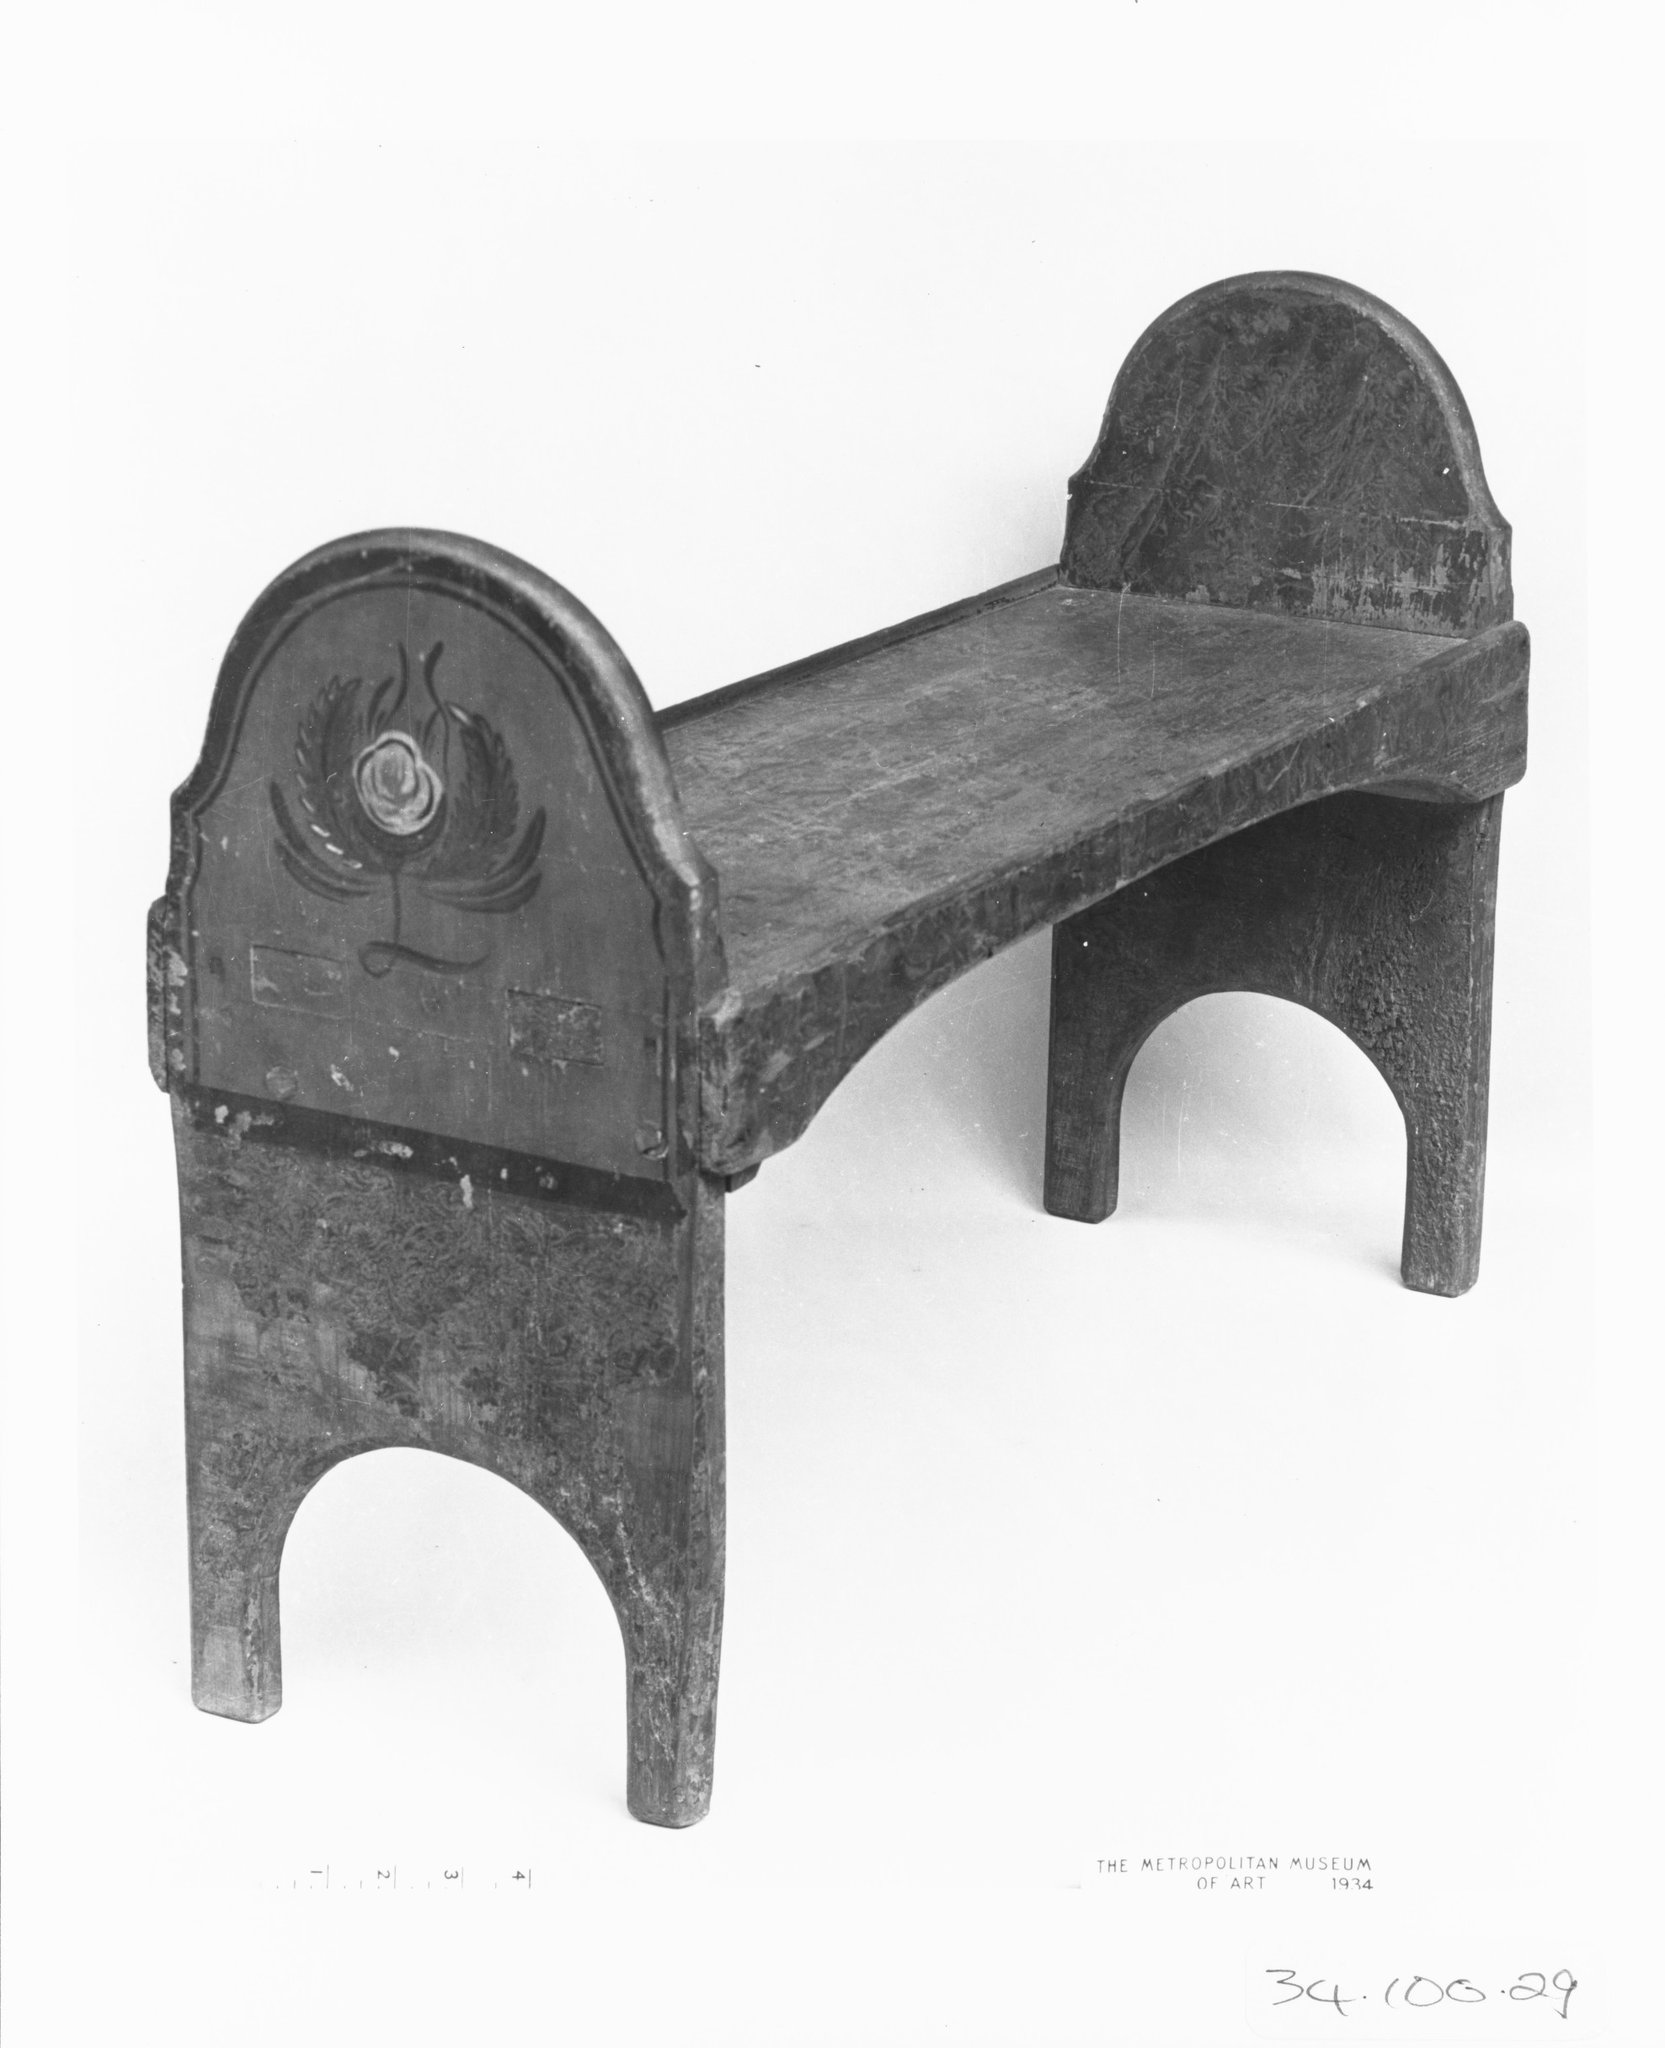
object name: sleigh seat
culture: american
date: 1800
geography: united states